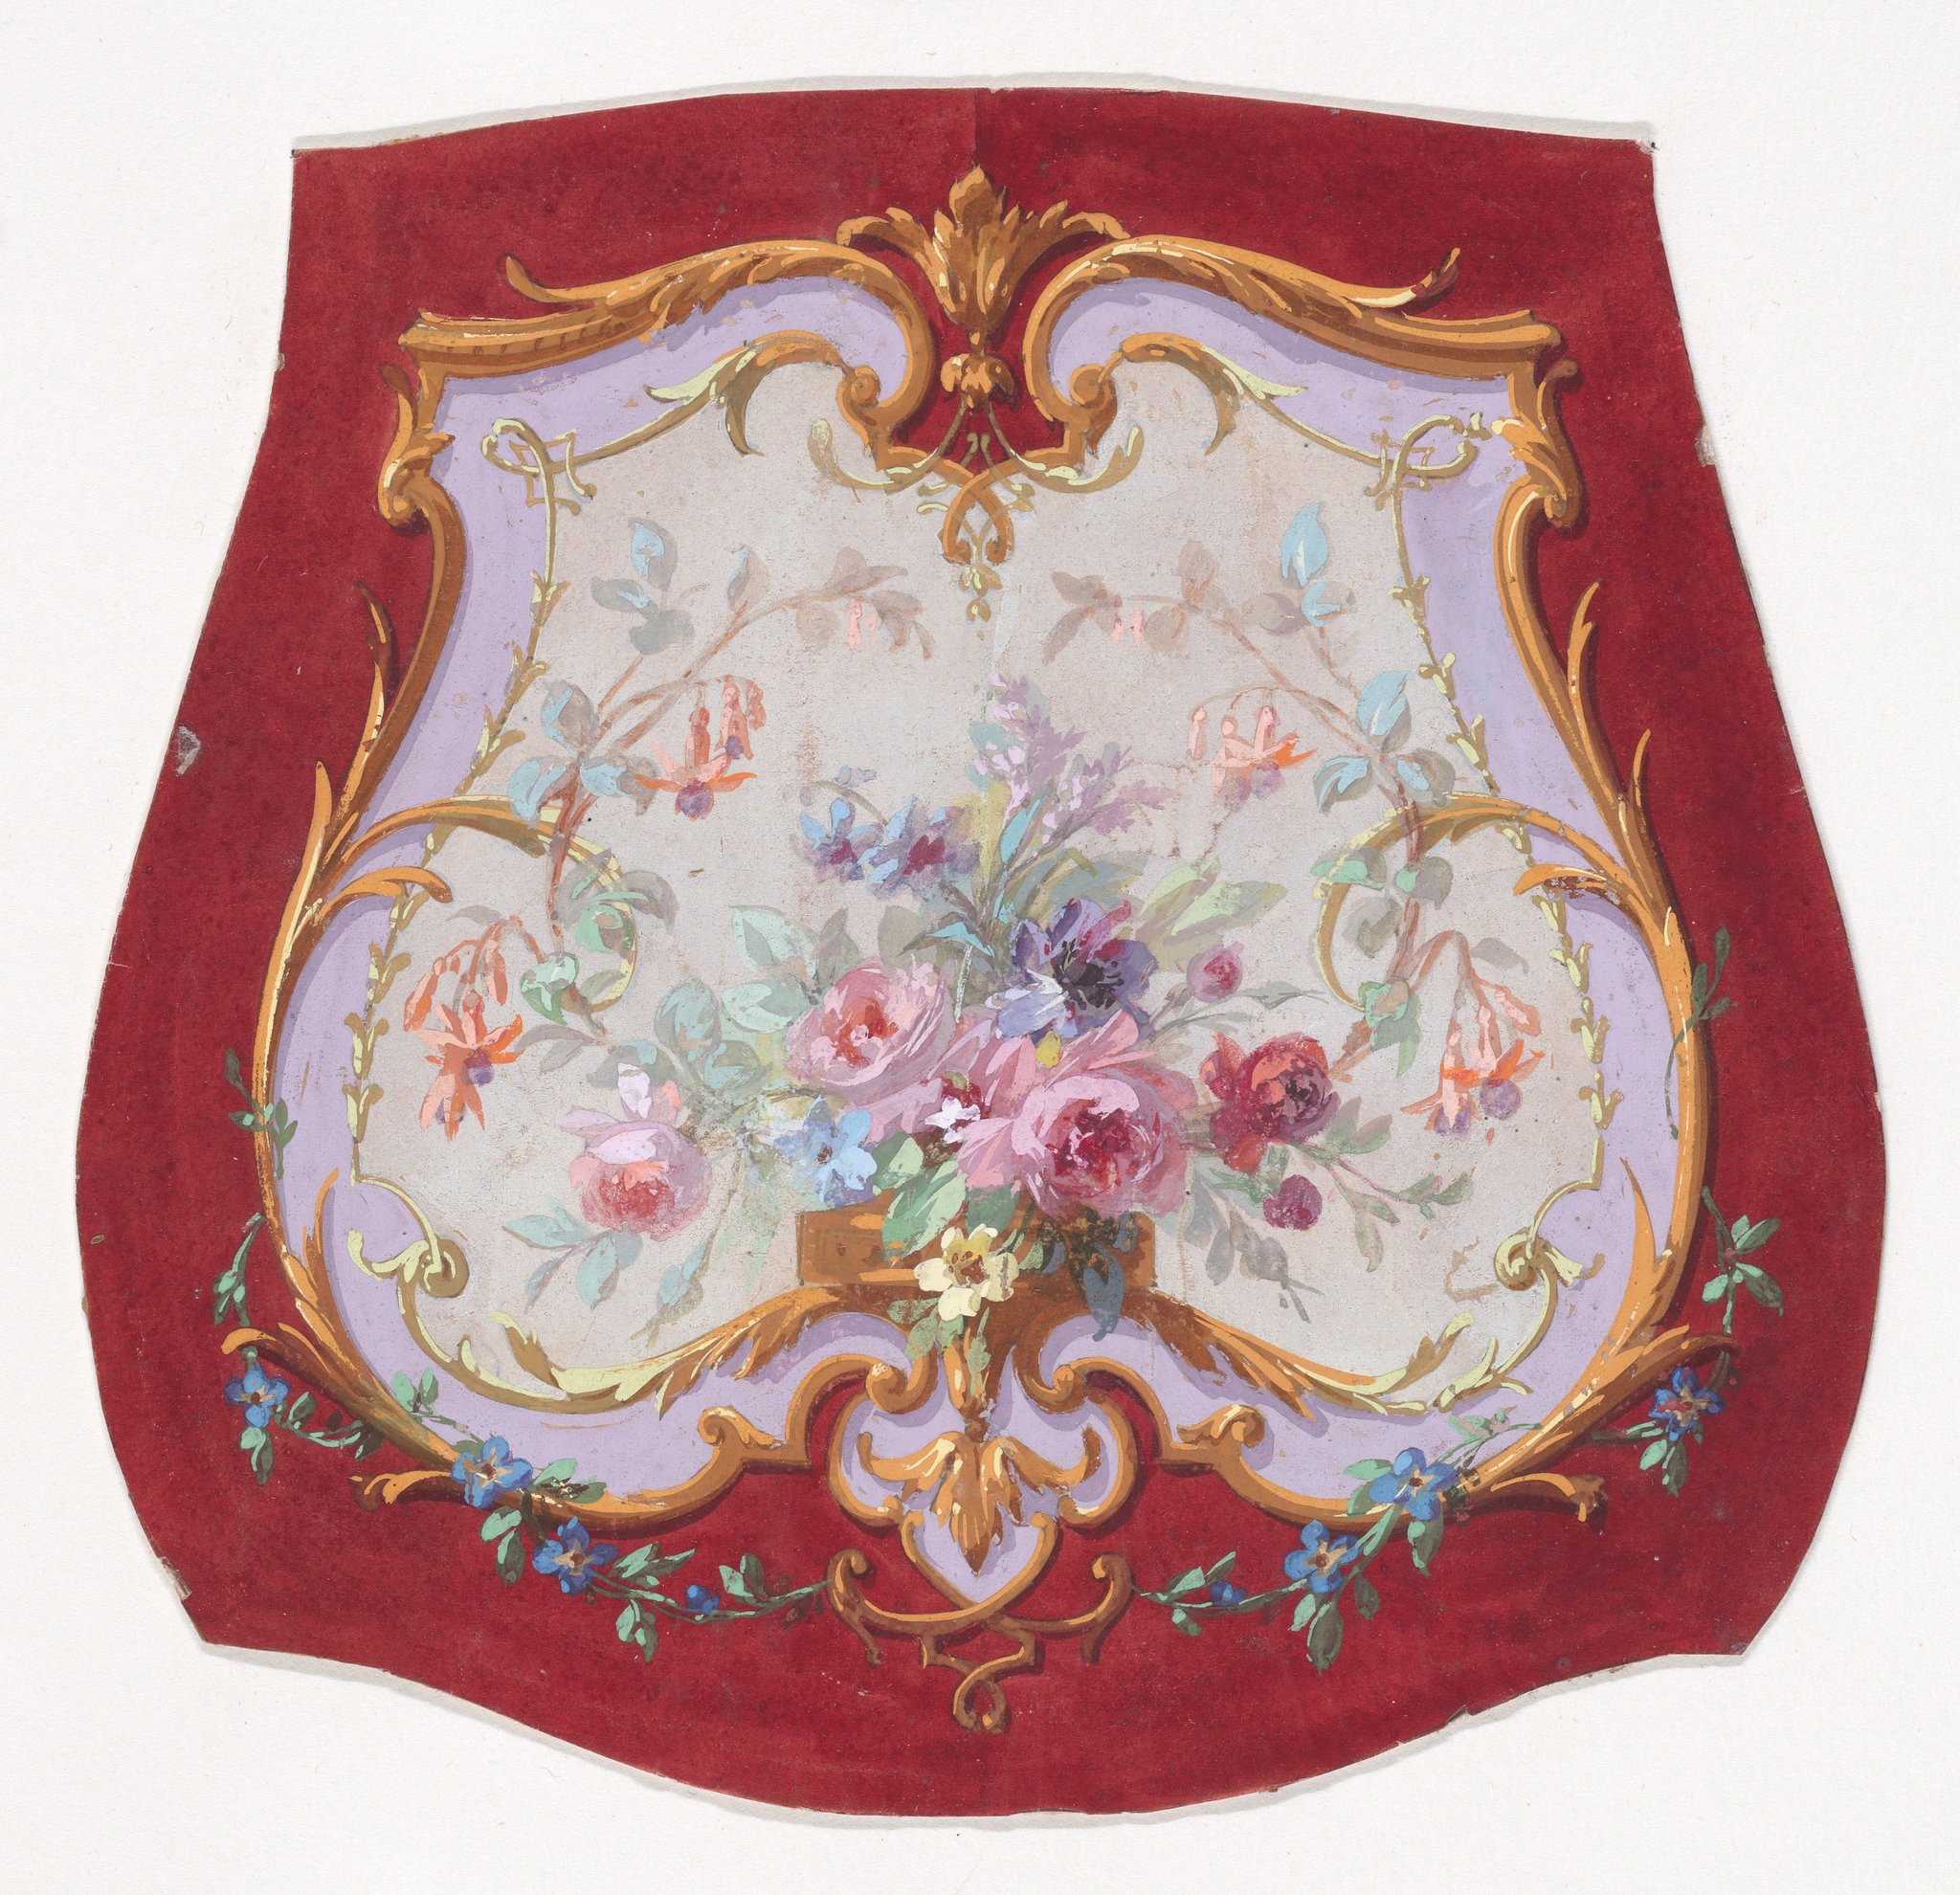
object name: drawing ornament architecture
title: Design for a Chair Seat Cover with Floral Motifs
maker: anonymous, french, 19th century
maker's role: designer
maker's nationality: french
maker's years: 1800-1900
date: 1850-1900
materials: watercolor